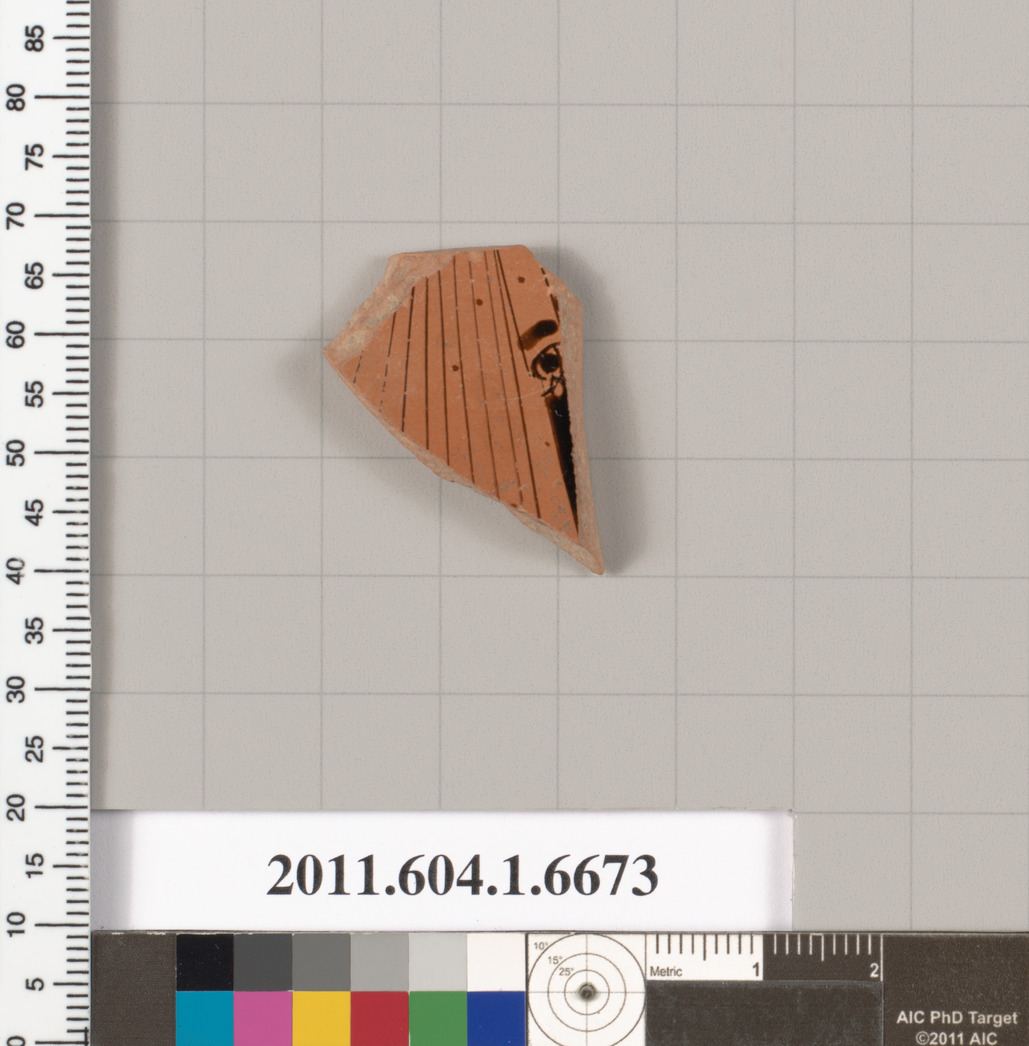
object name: kylix fragment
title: Terracotta fragment of a kylix (drinking cup)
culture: greek, attic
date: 490-470 BCE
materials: terracotta